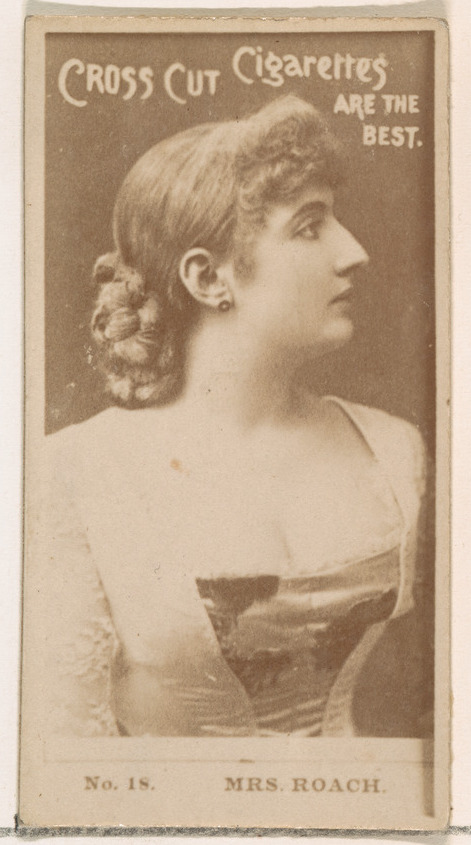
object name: print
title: Card Number 18, Mrs. Roach, from the Actors and Actresses series (N145-2) issued by Duke Sons & Co. to promote Cross Cut Cigarettes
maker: w. duke, sons & co.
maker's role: publisher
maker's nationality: american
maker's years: 1870-1920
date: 1880-1889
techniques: albumen silver print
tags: women,actresses